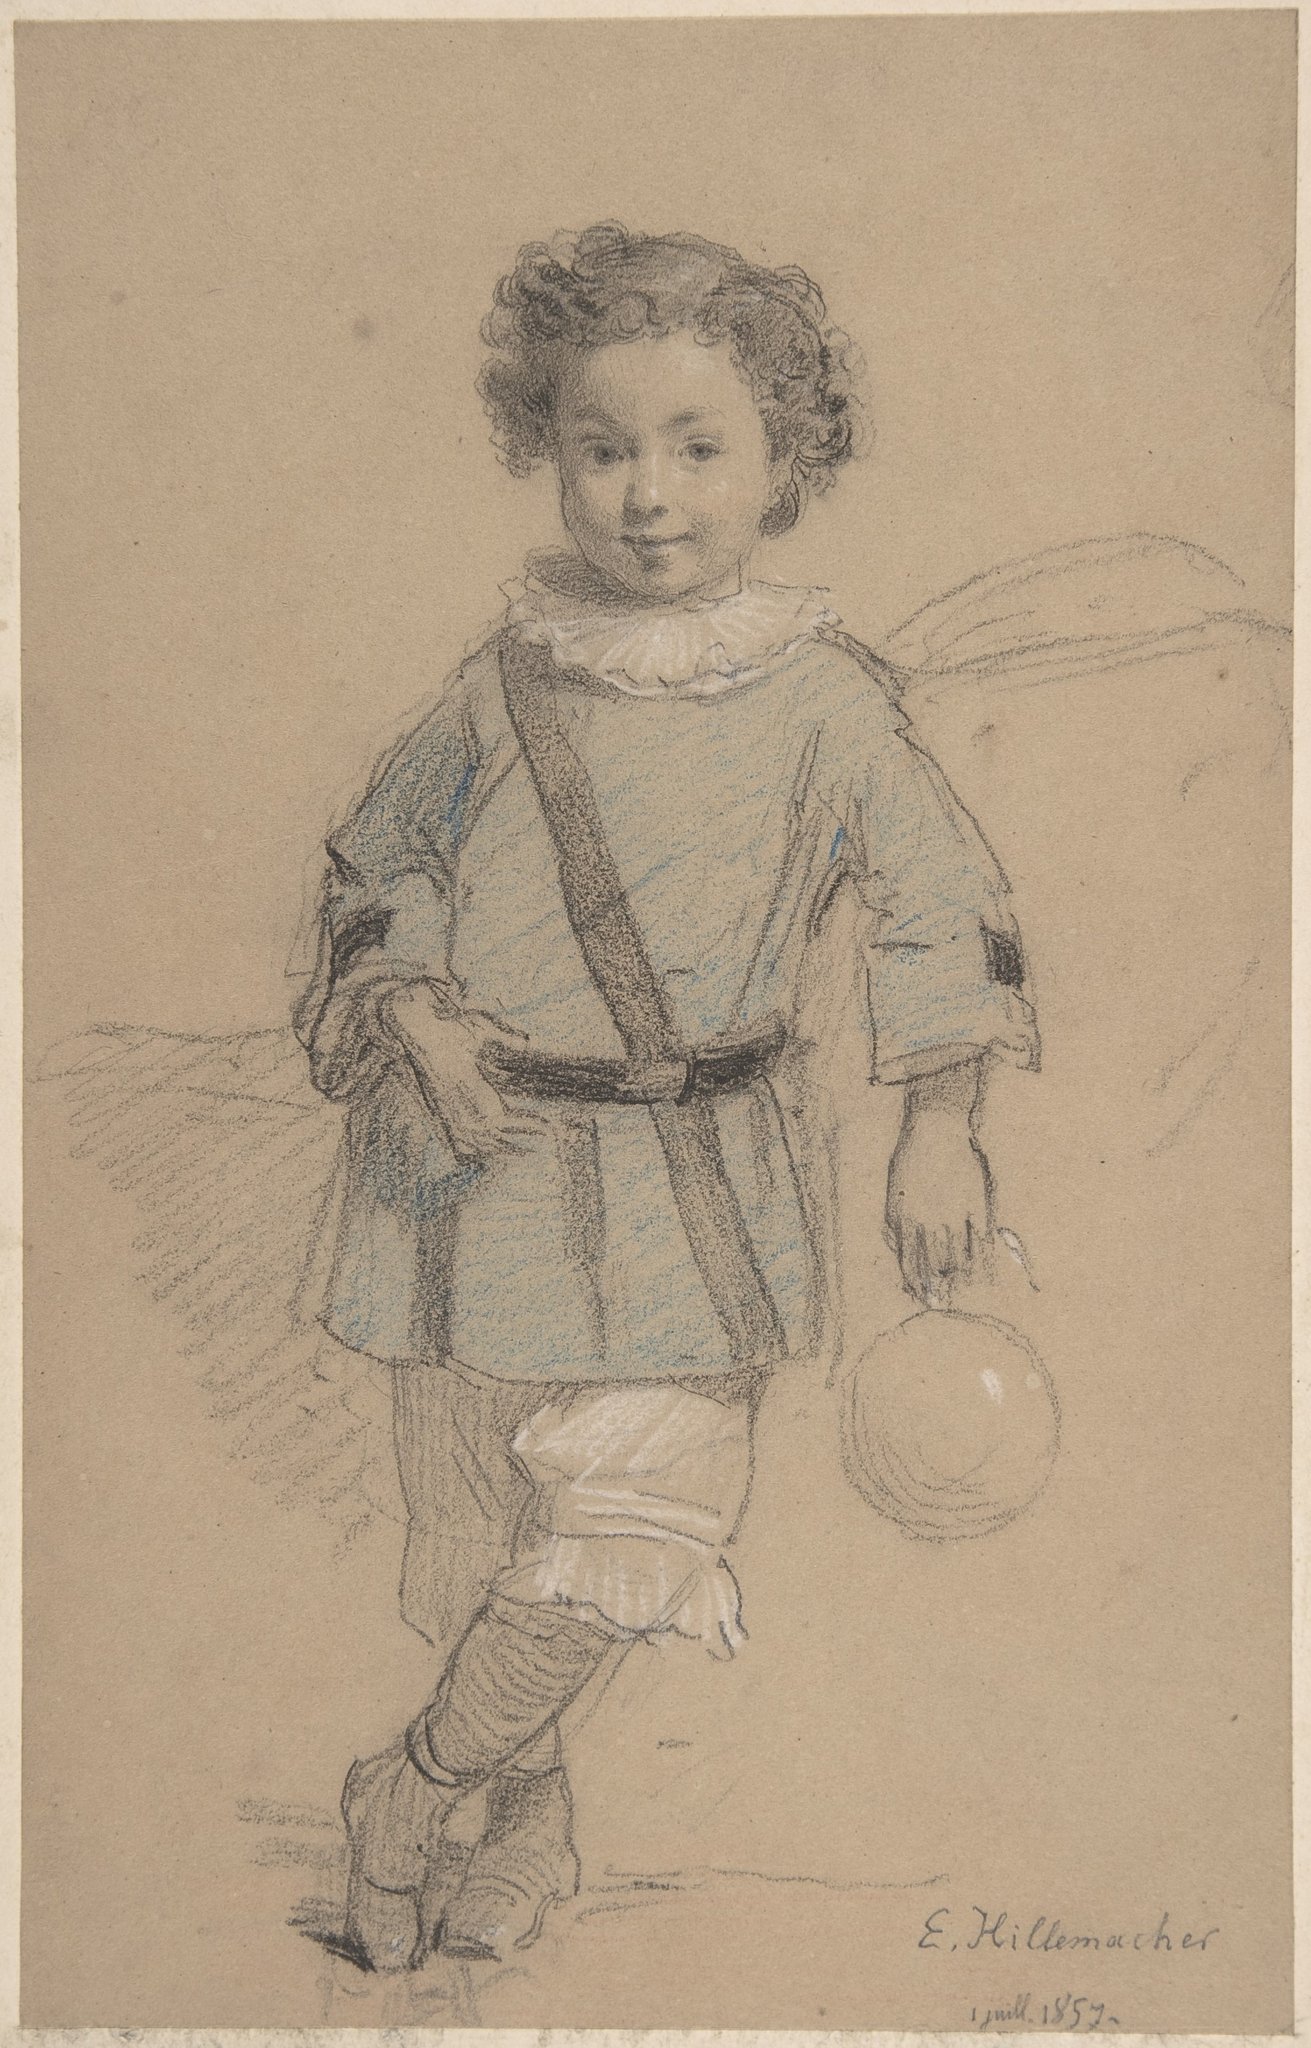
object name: drawing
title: Sketch of a Young Boy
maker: eugène-ernest hillemacher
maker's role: artist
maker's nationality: french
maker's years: 1818-1887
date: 1857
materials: chalk, pastel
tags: boys